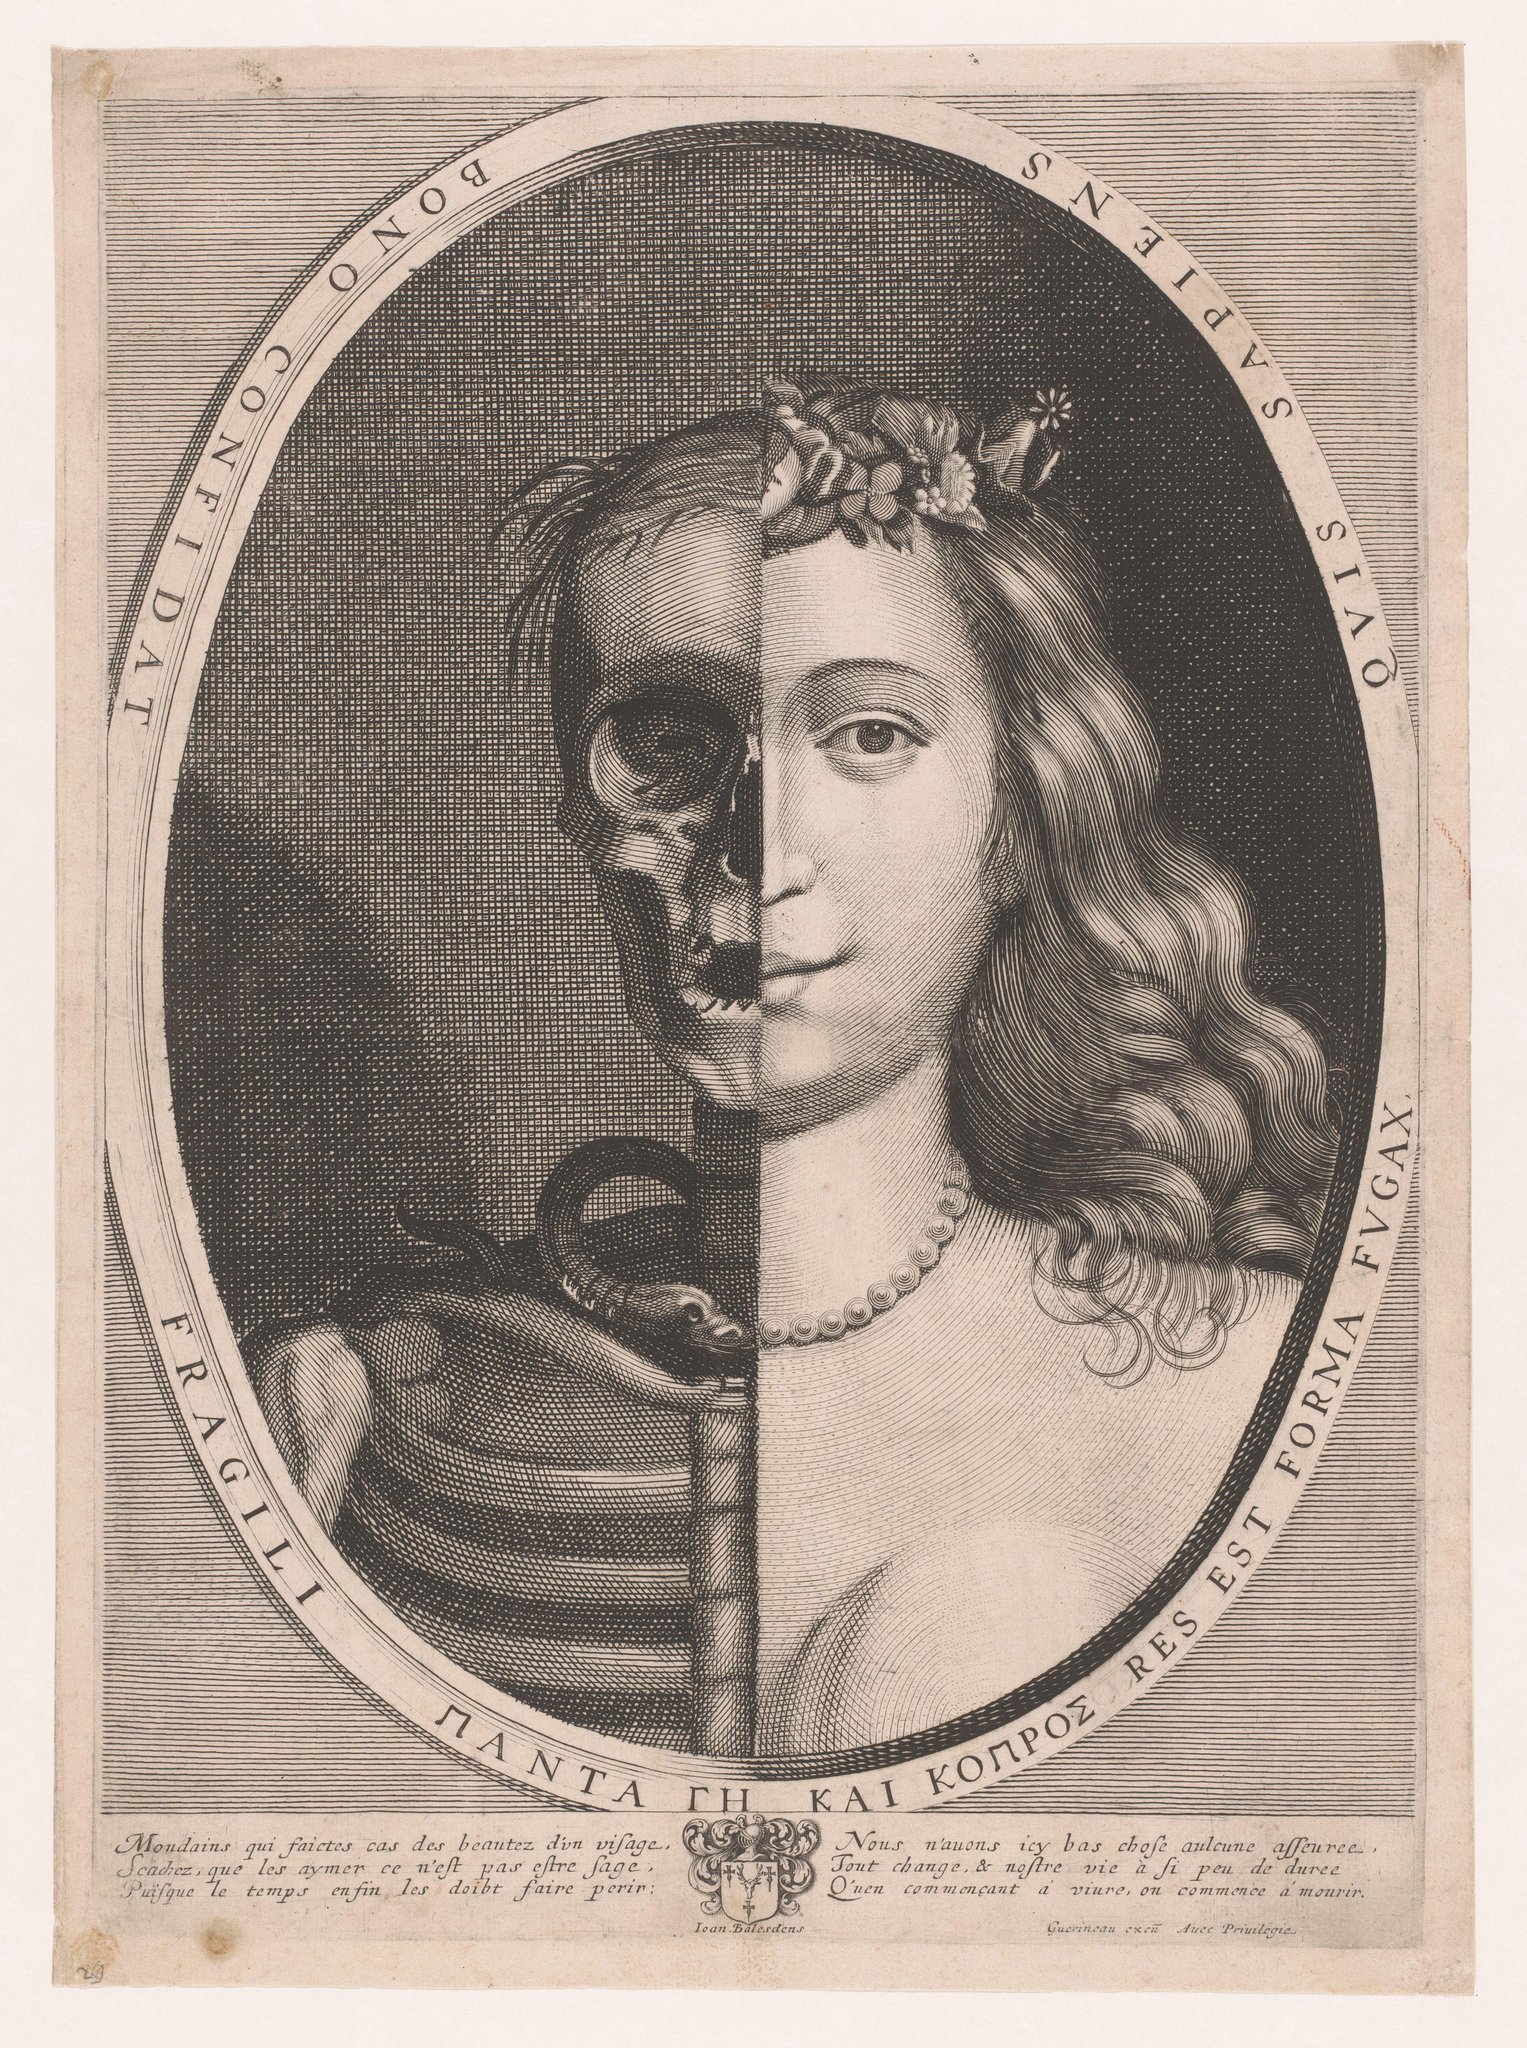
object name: print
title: Buste van een half skelet en een half jonge vrouw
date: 1615-1664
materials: paper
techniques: engraving, etching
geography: france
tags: skull as symbol of 'vanitas', (human) skeleton - aa - female human figure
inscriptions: caption: ‘Mondains qui faictes cas des beautez d'un visage,/ Scachez, que les aymer ce n'est pas estre sage,/ (...)’, collector's mark: Lugt 240